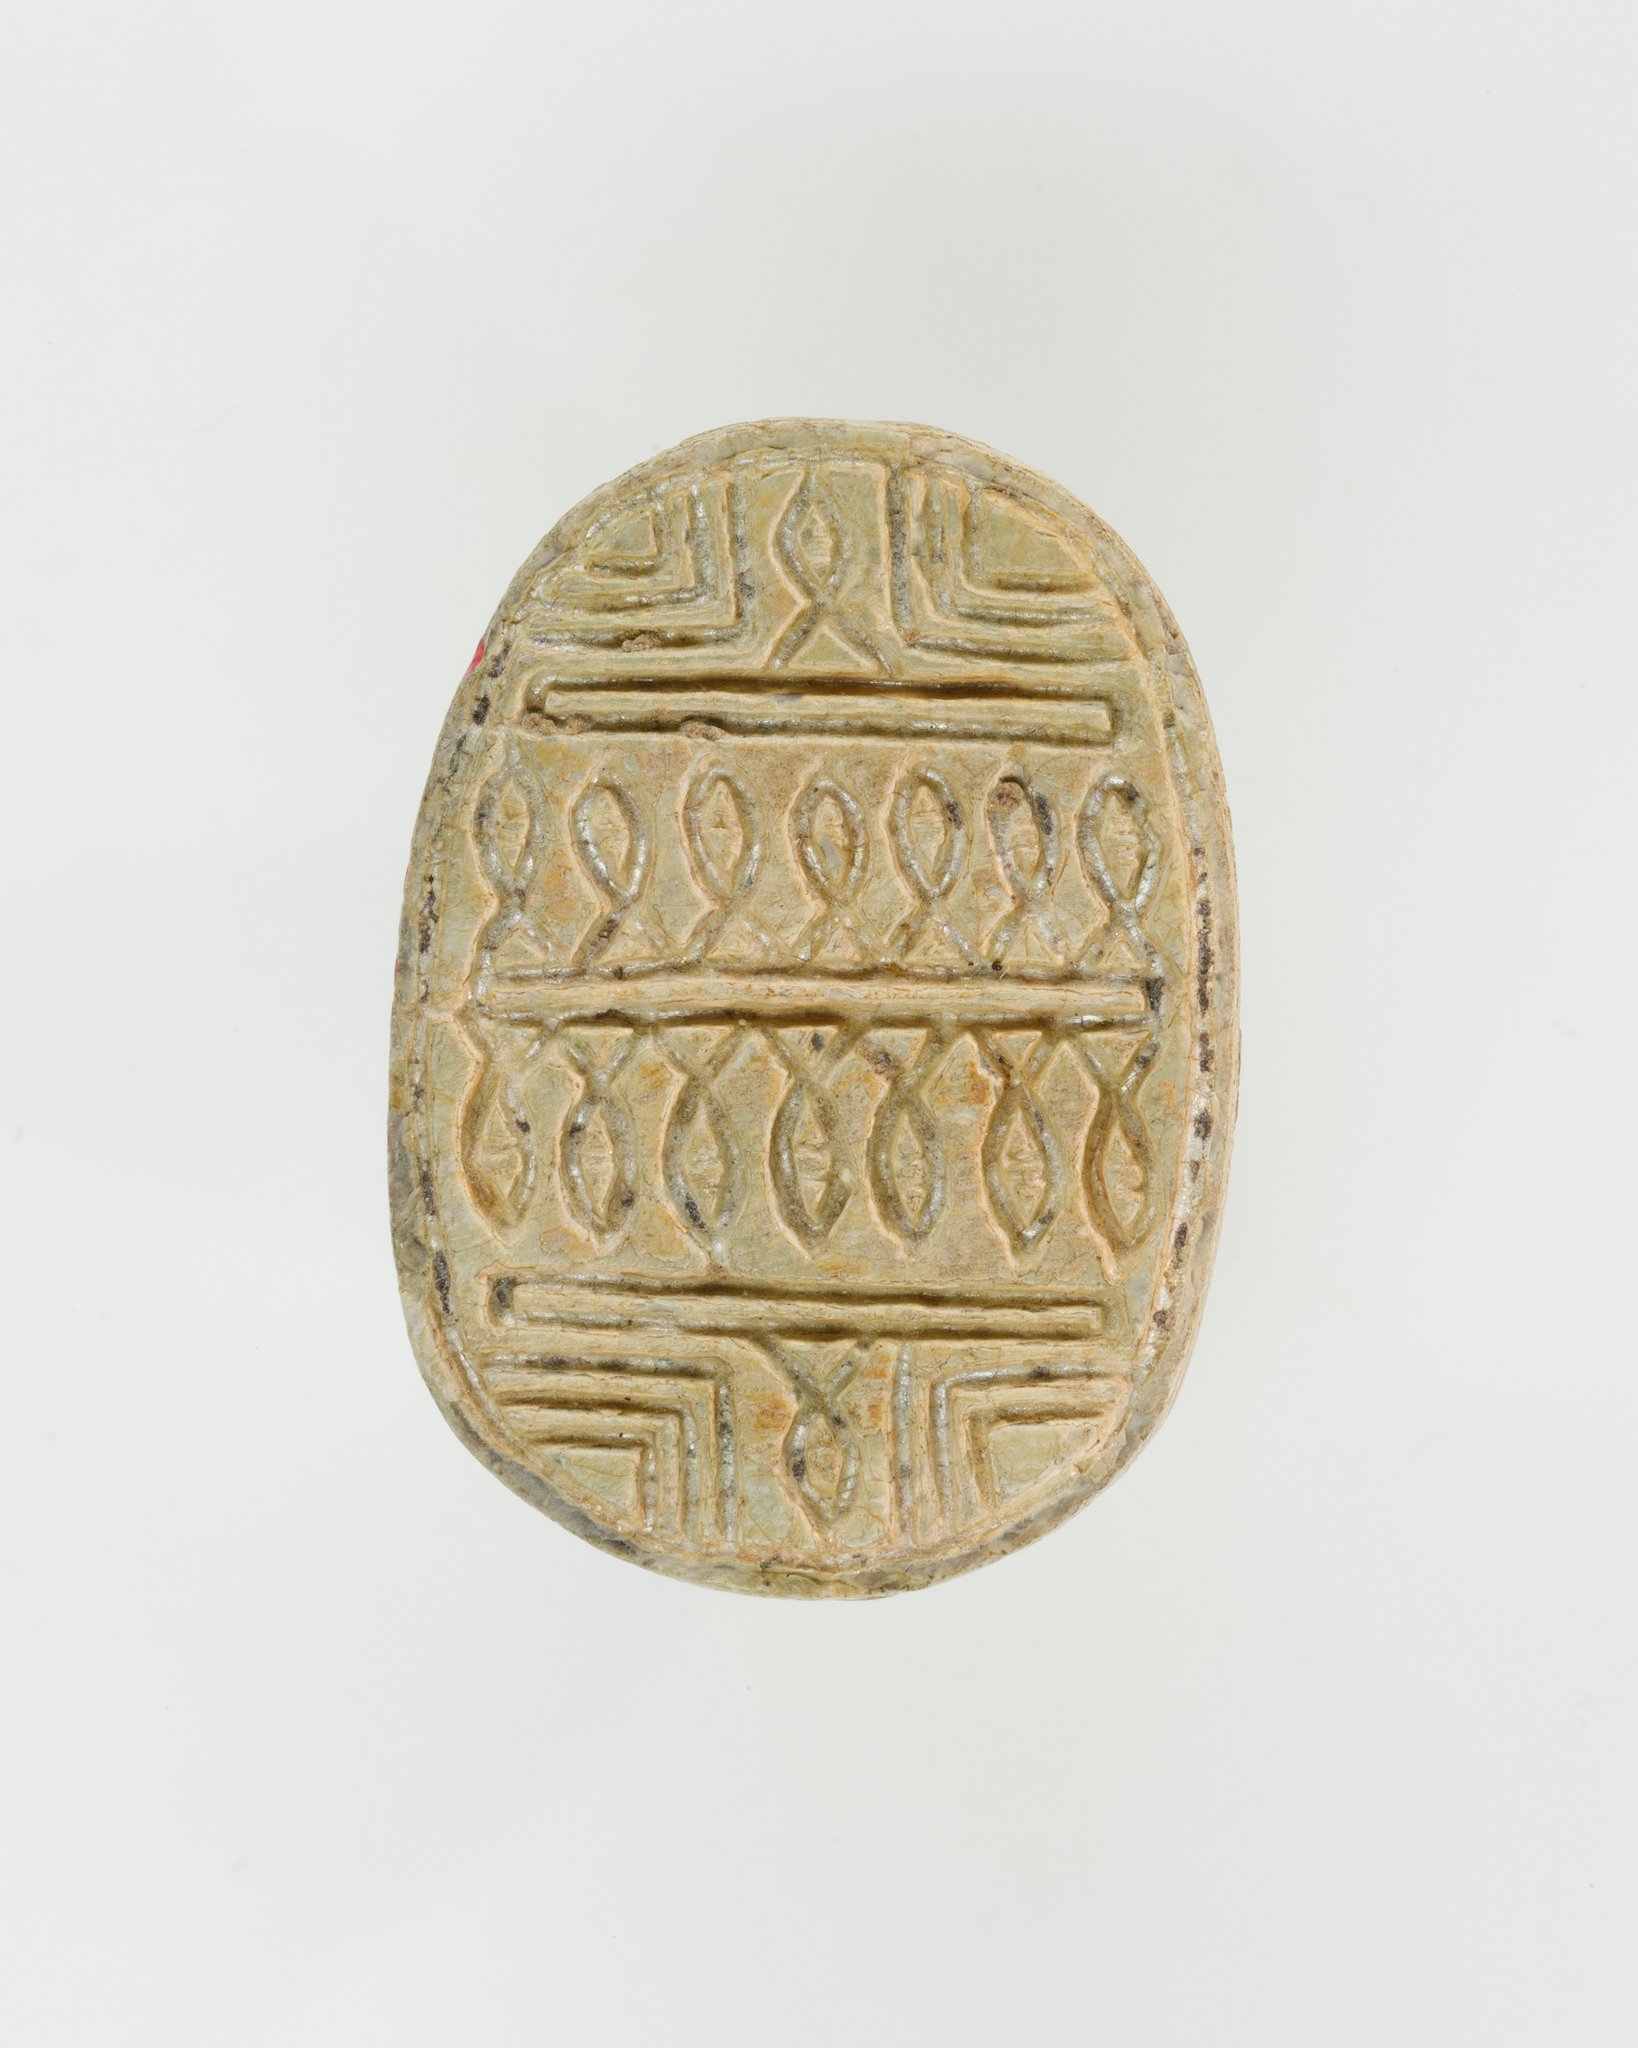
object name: scarab, loop, sa hieroglyph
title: Scarab Decorated with Loops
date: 1770-1670 BCE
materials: glaze, stone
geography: egypt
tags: scarabs